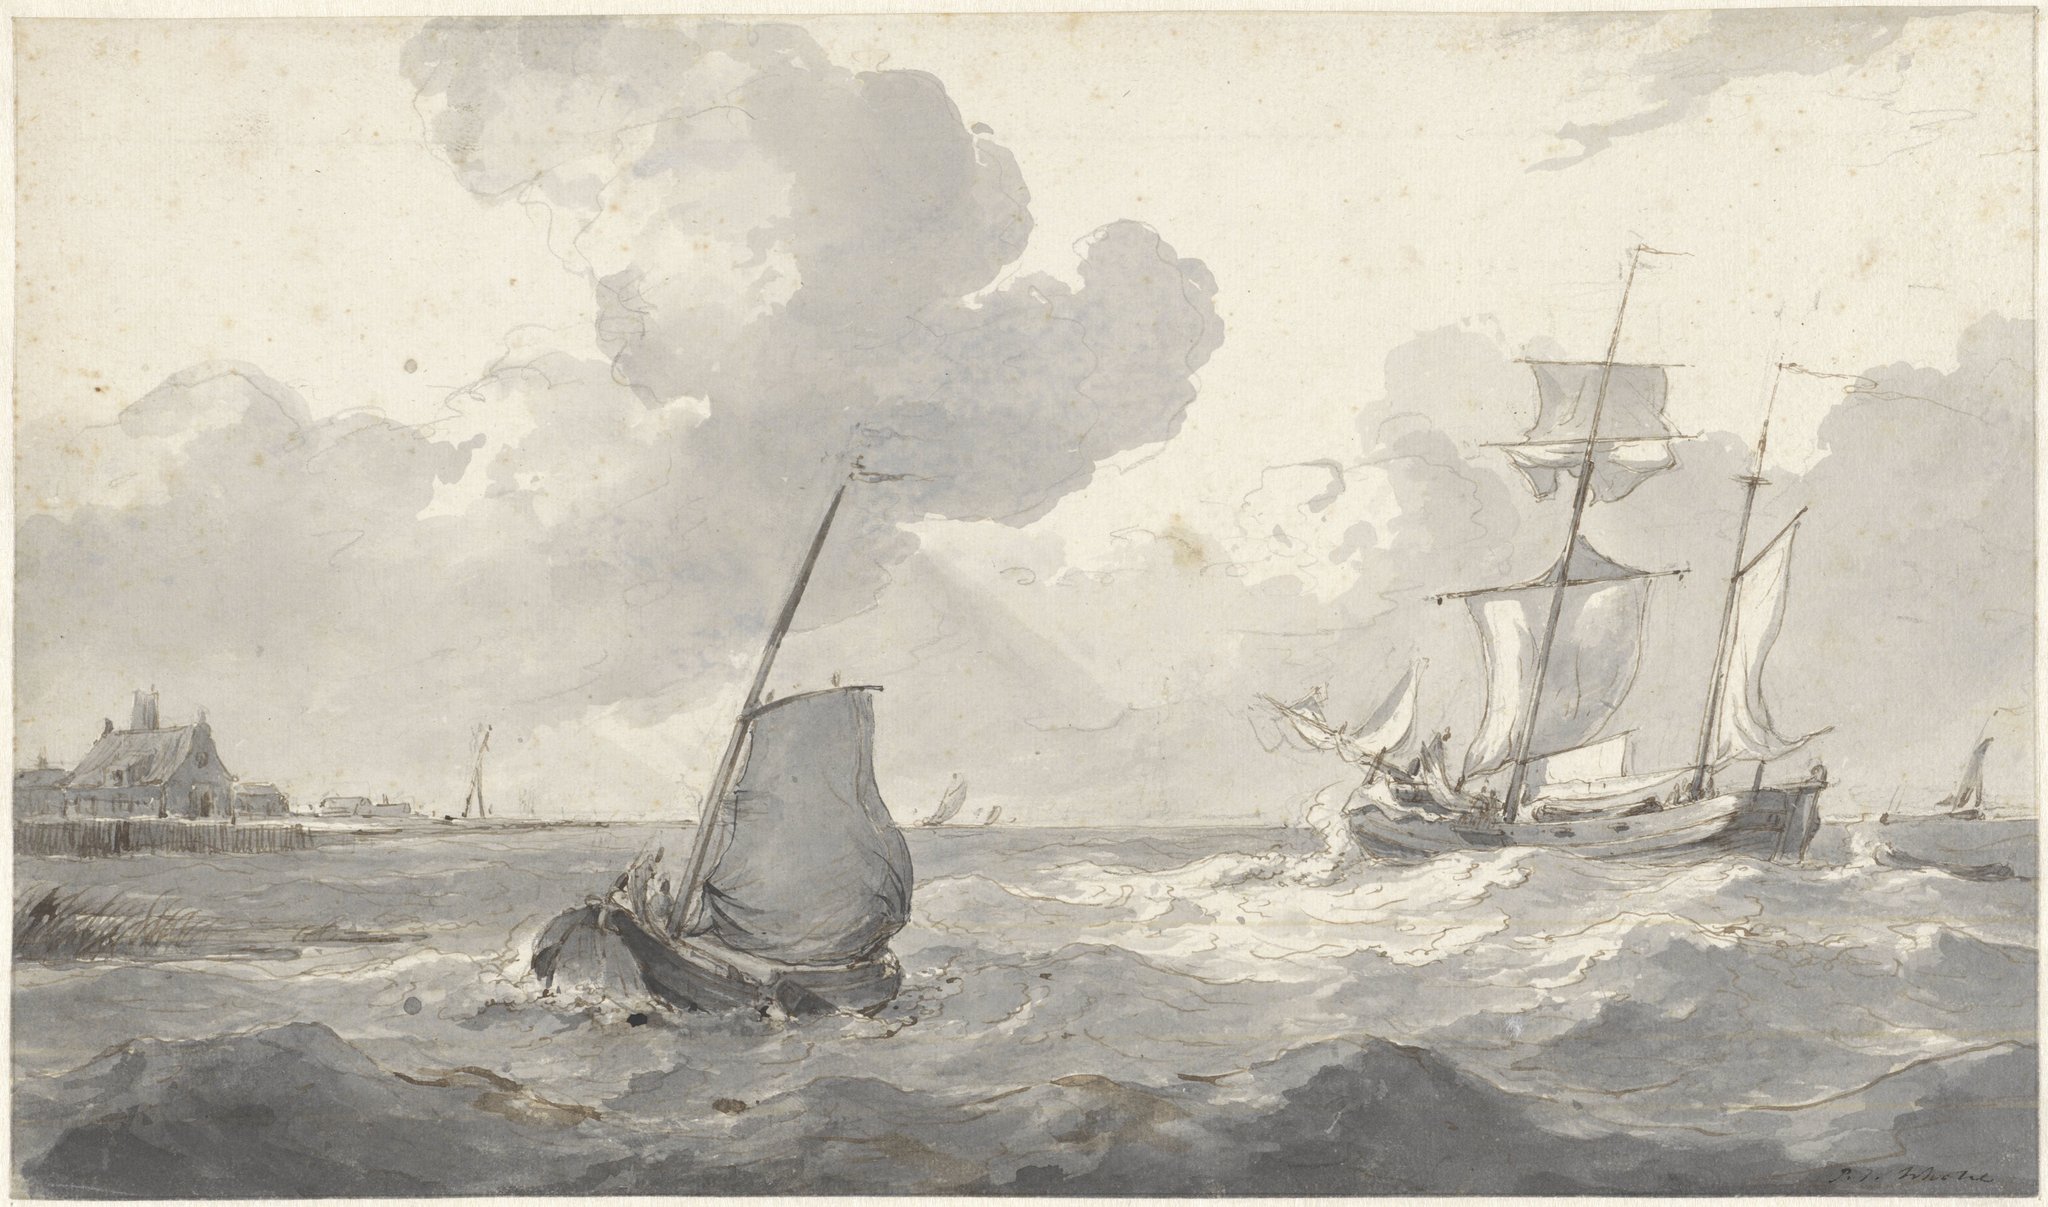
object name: drawing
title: Tweemaster en vissersboot voor de kust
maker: petrus johannes schotel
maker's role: draughtsman, painter, print maker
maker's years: 1808-1865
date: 1818-1865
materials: ink, paper, pencil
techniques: brush, pen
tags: ships (in general), sea (seascape)